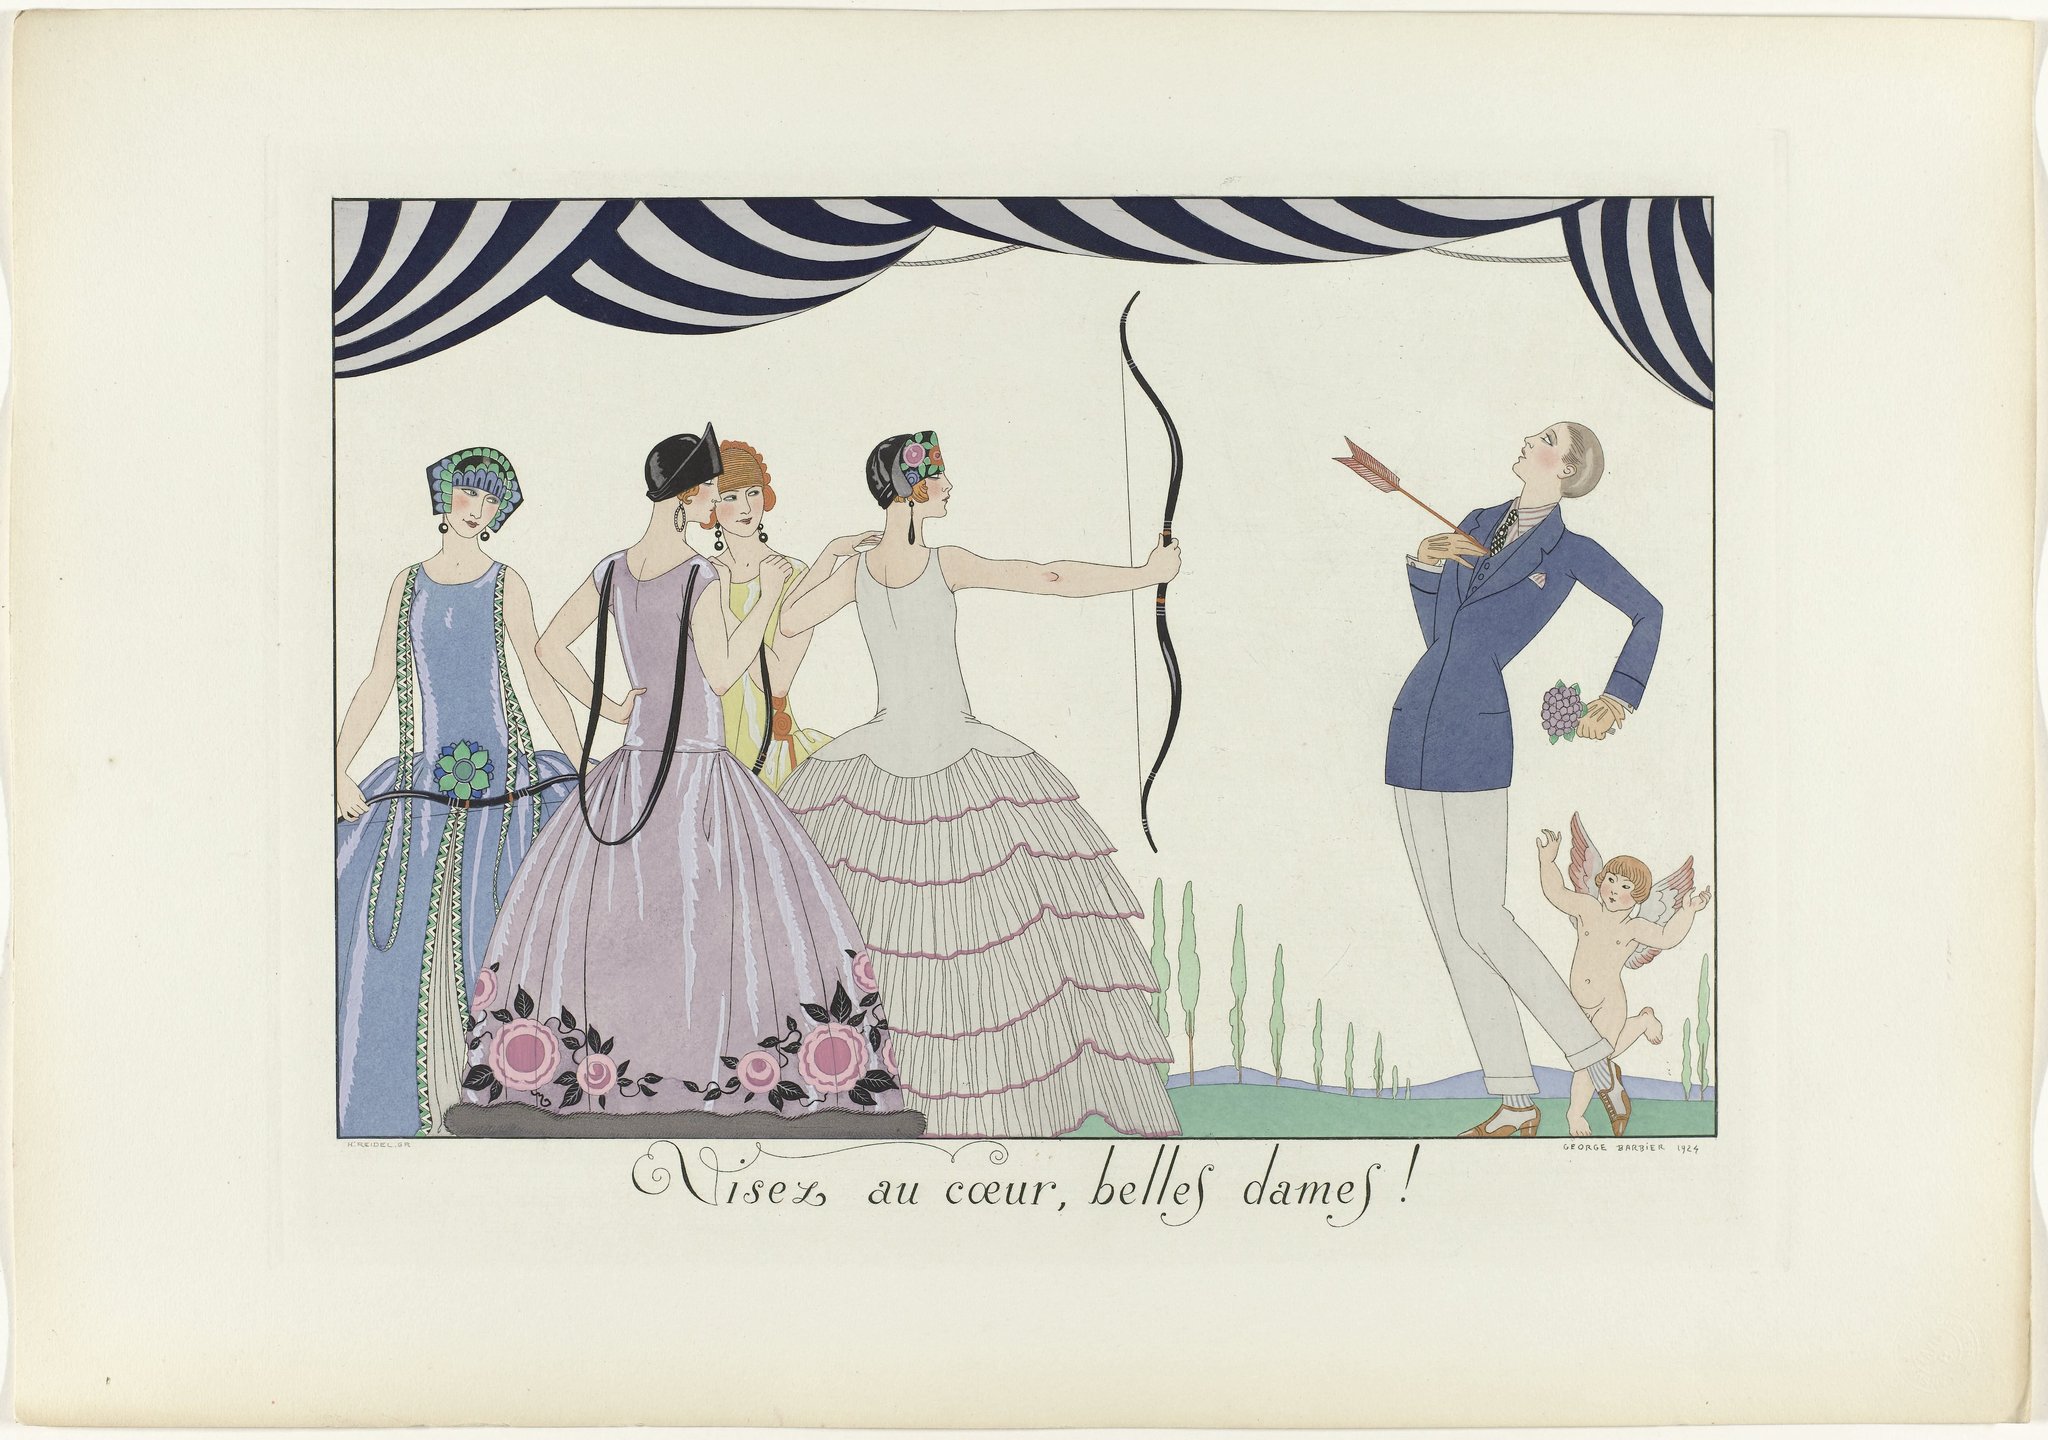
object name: fashion print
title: Visez au coeur, belles dames!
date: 1924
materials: paper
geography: paris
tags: fashion plates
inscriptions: date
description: Uit serie Le Bonheur du Jour ou Les Graces à la Mode.